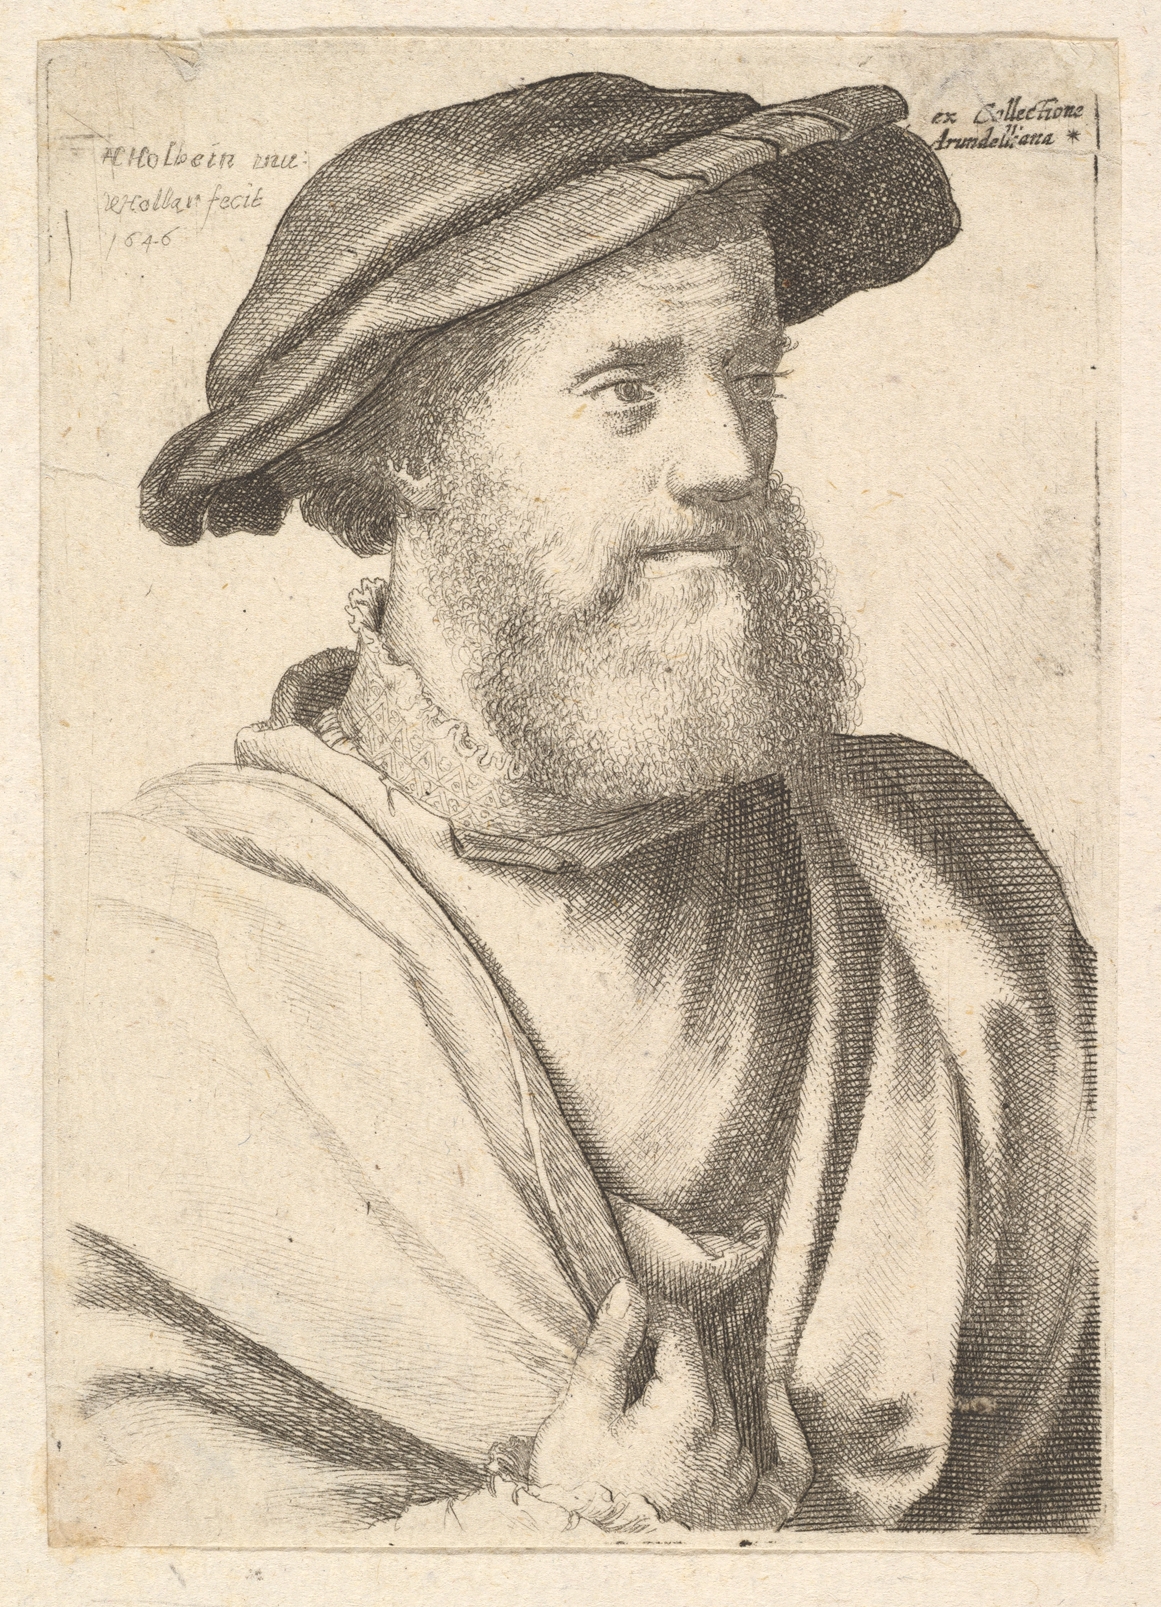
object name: print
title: A bearded man after Hans Holbein (?)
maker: wenceslaus hollar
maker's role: artist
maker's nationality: bohemian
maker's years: 1607-1677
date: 1646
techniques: etching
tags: men,portraits